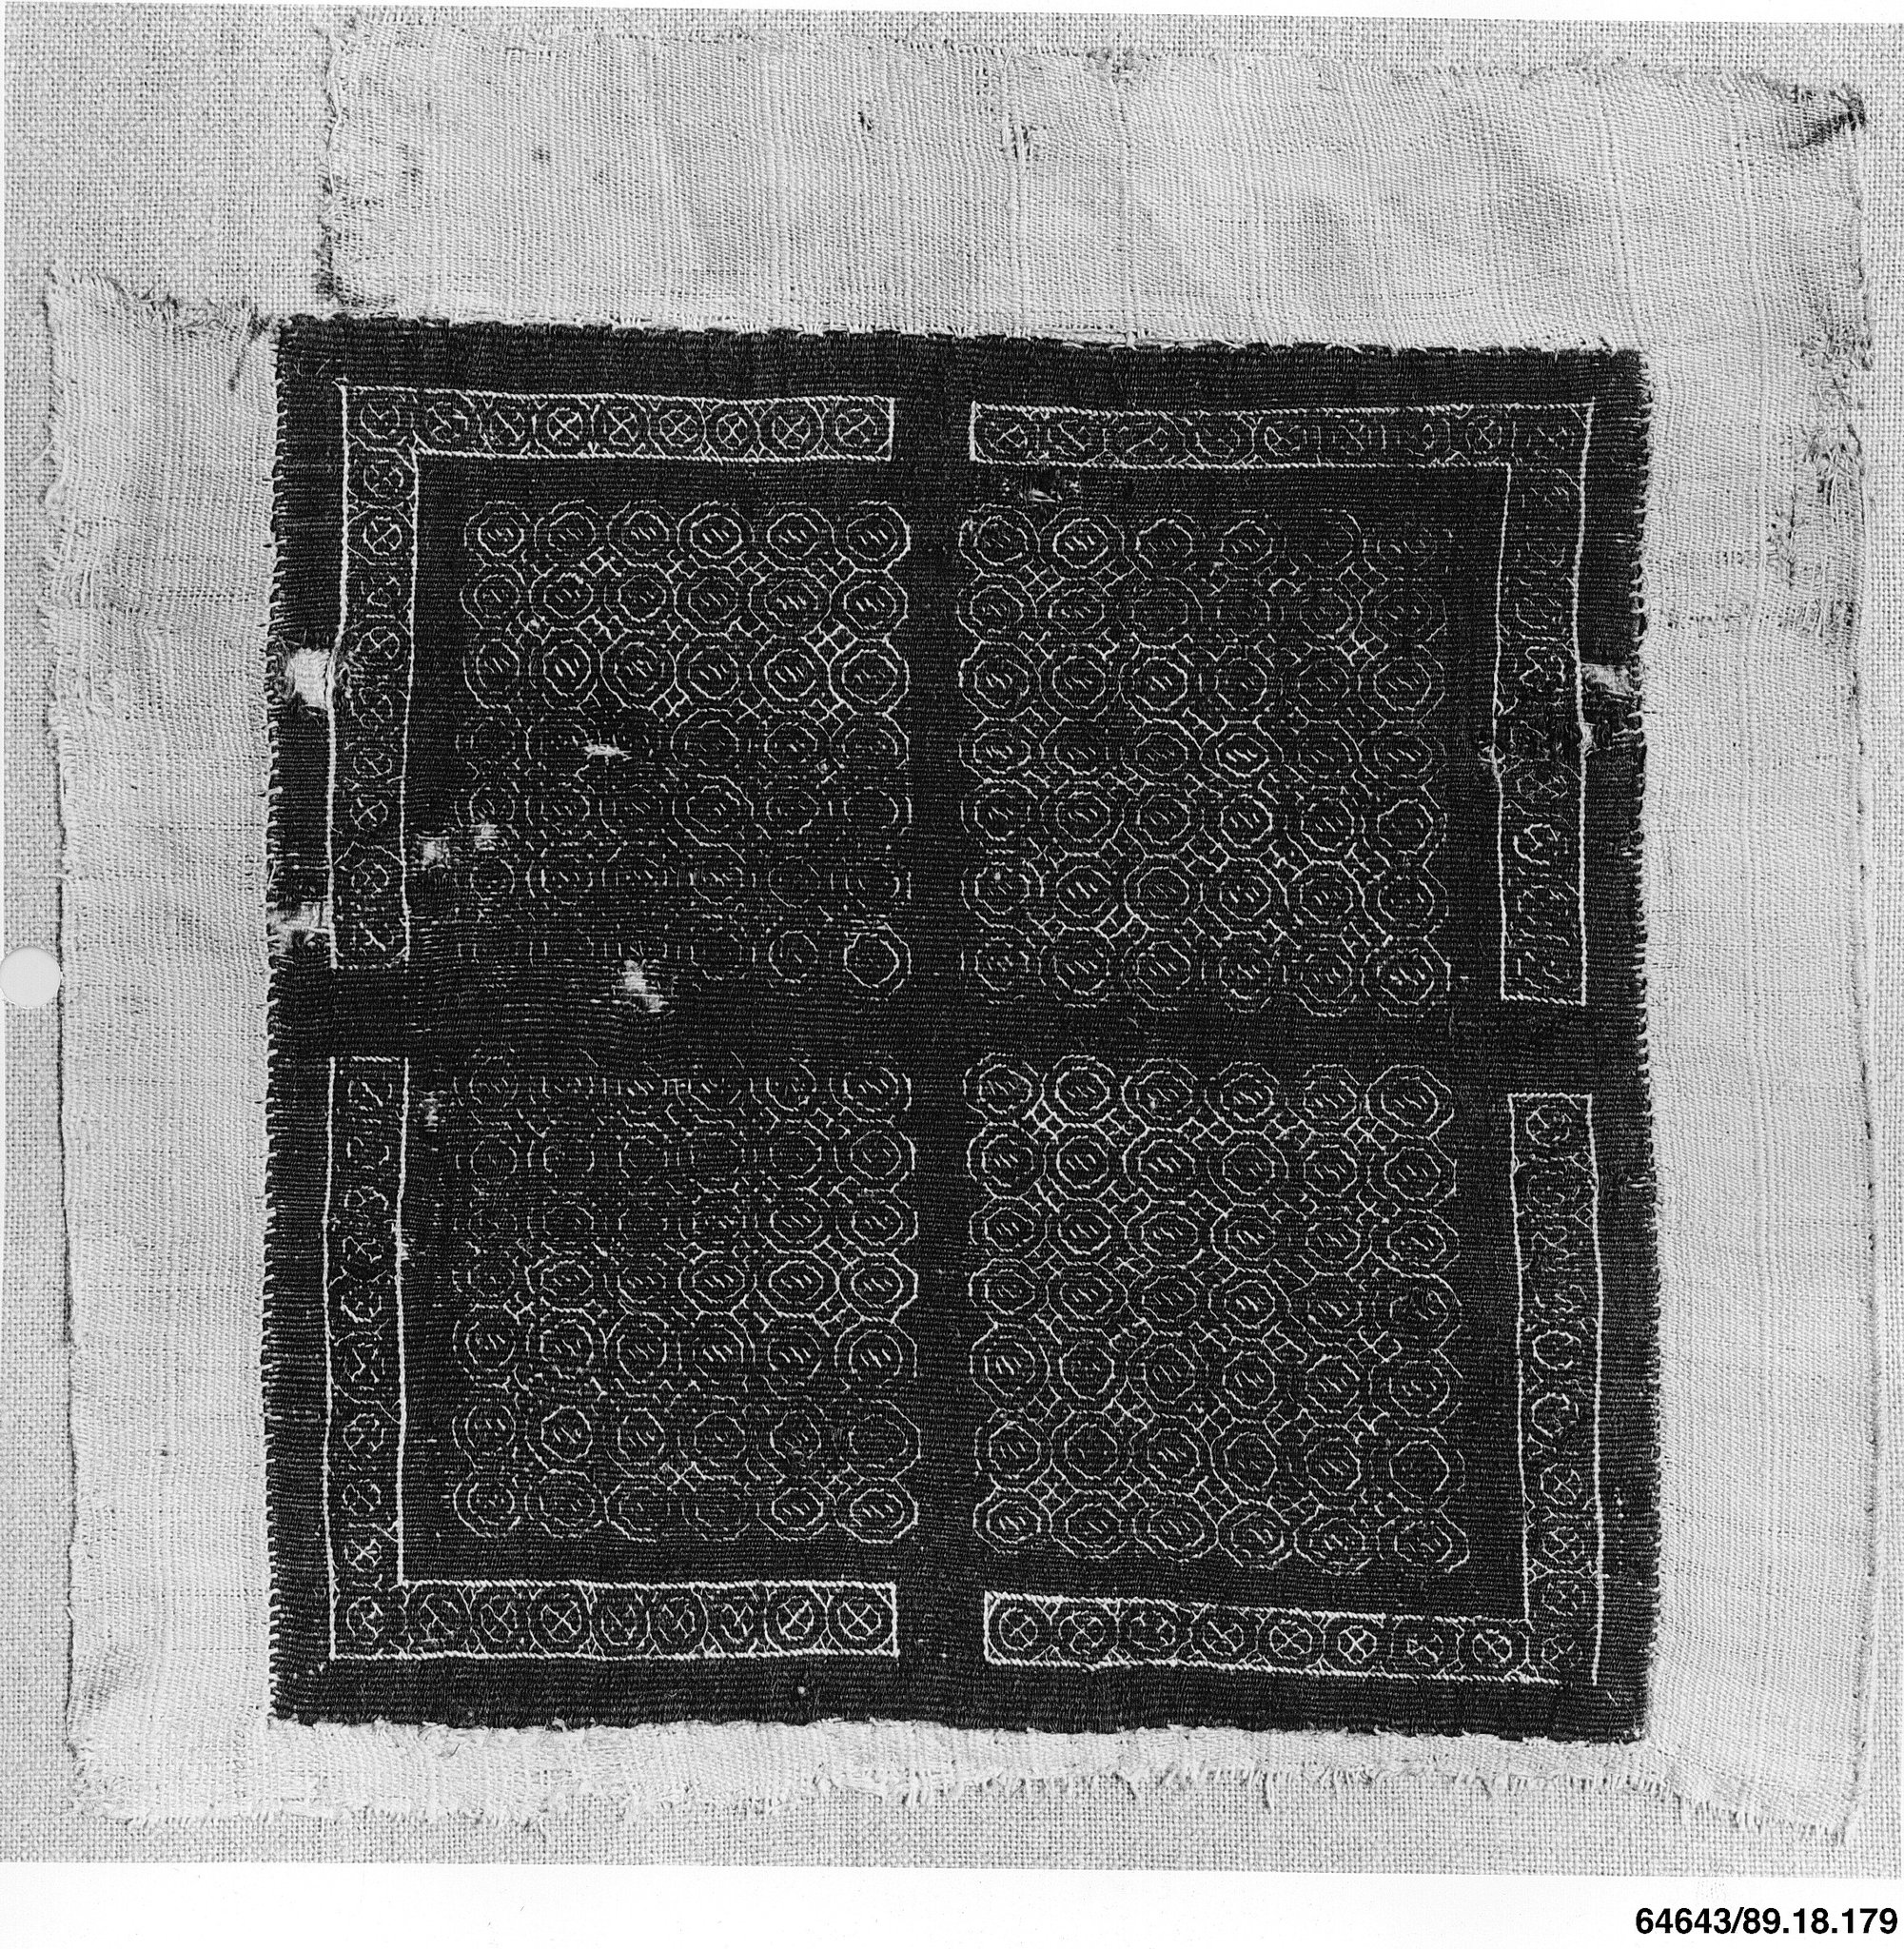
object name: textile fragment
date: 201-400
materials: linen, wool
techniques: weave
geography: egypt